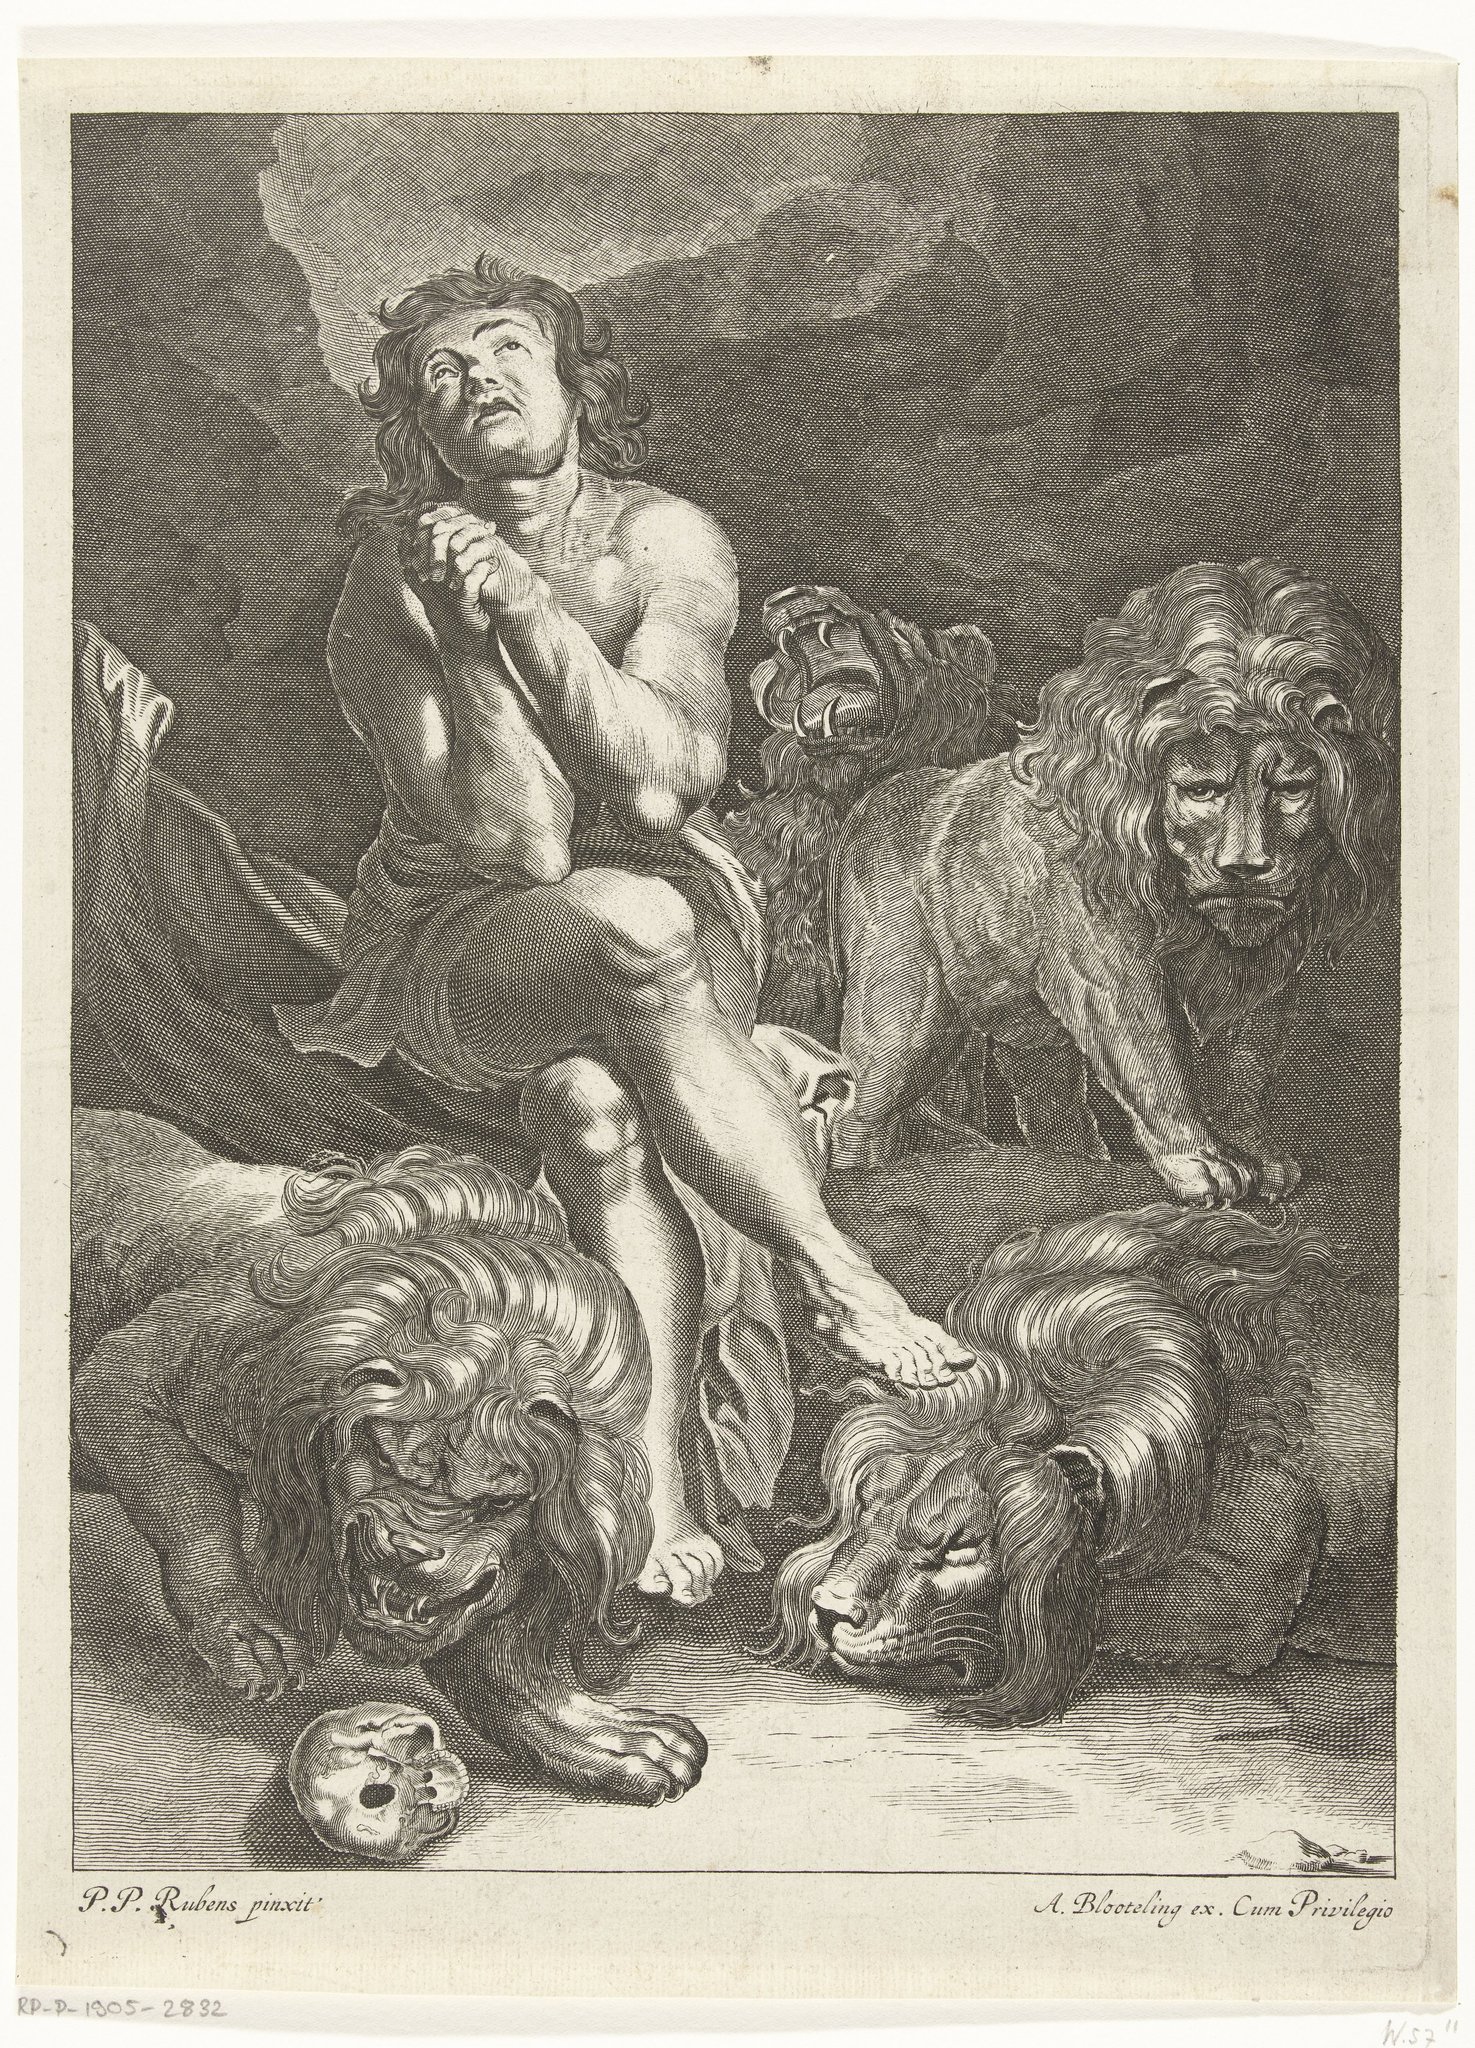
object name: print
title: Daniël in de leeuwenkuil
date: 1655-1690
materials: paper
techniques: engraving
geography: amsterdam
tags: daniel sitting unharmed in the lion's den, surrounded by lions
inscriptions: collector's mark: Lugt 2228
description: Daniël zit met gevouwen handen en opgeheven hoofd in de leeuwenkuil. Vier leeuwen struinen om hem heen. Linksvoor ligt een doodshoofd.